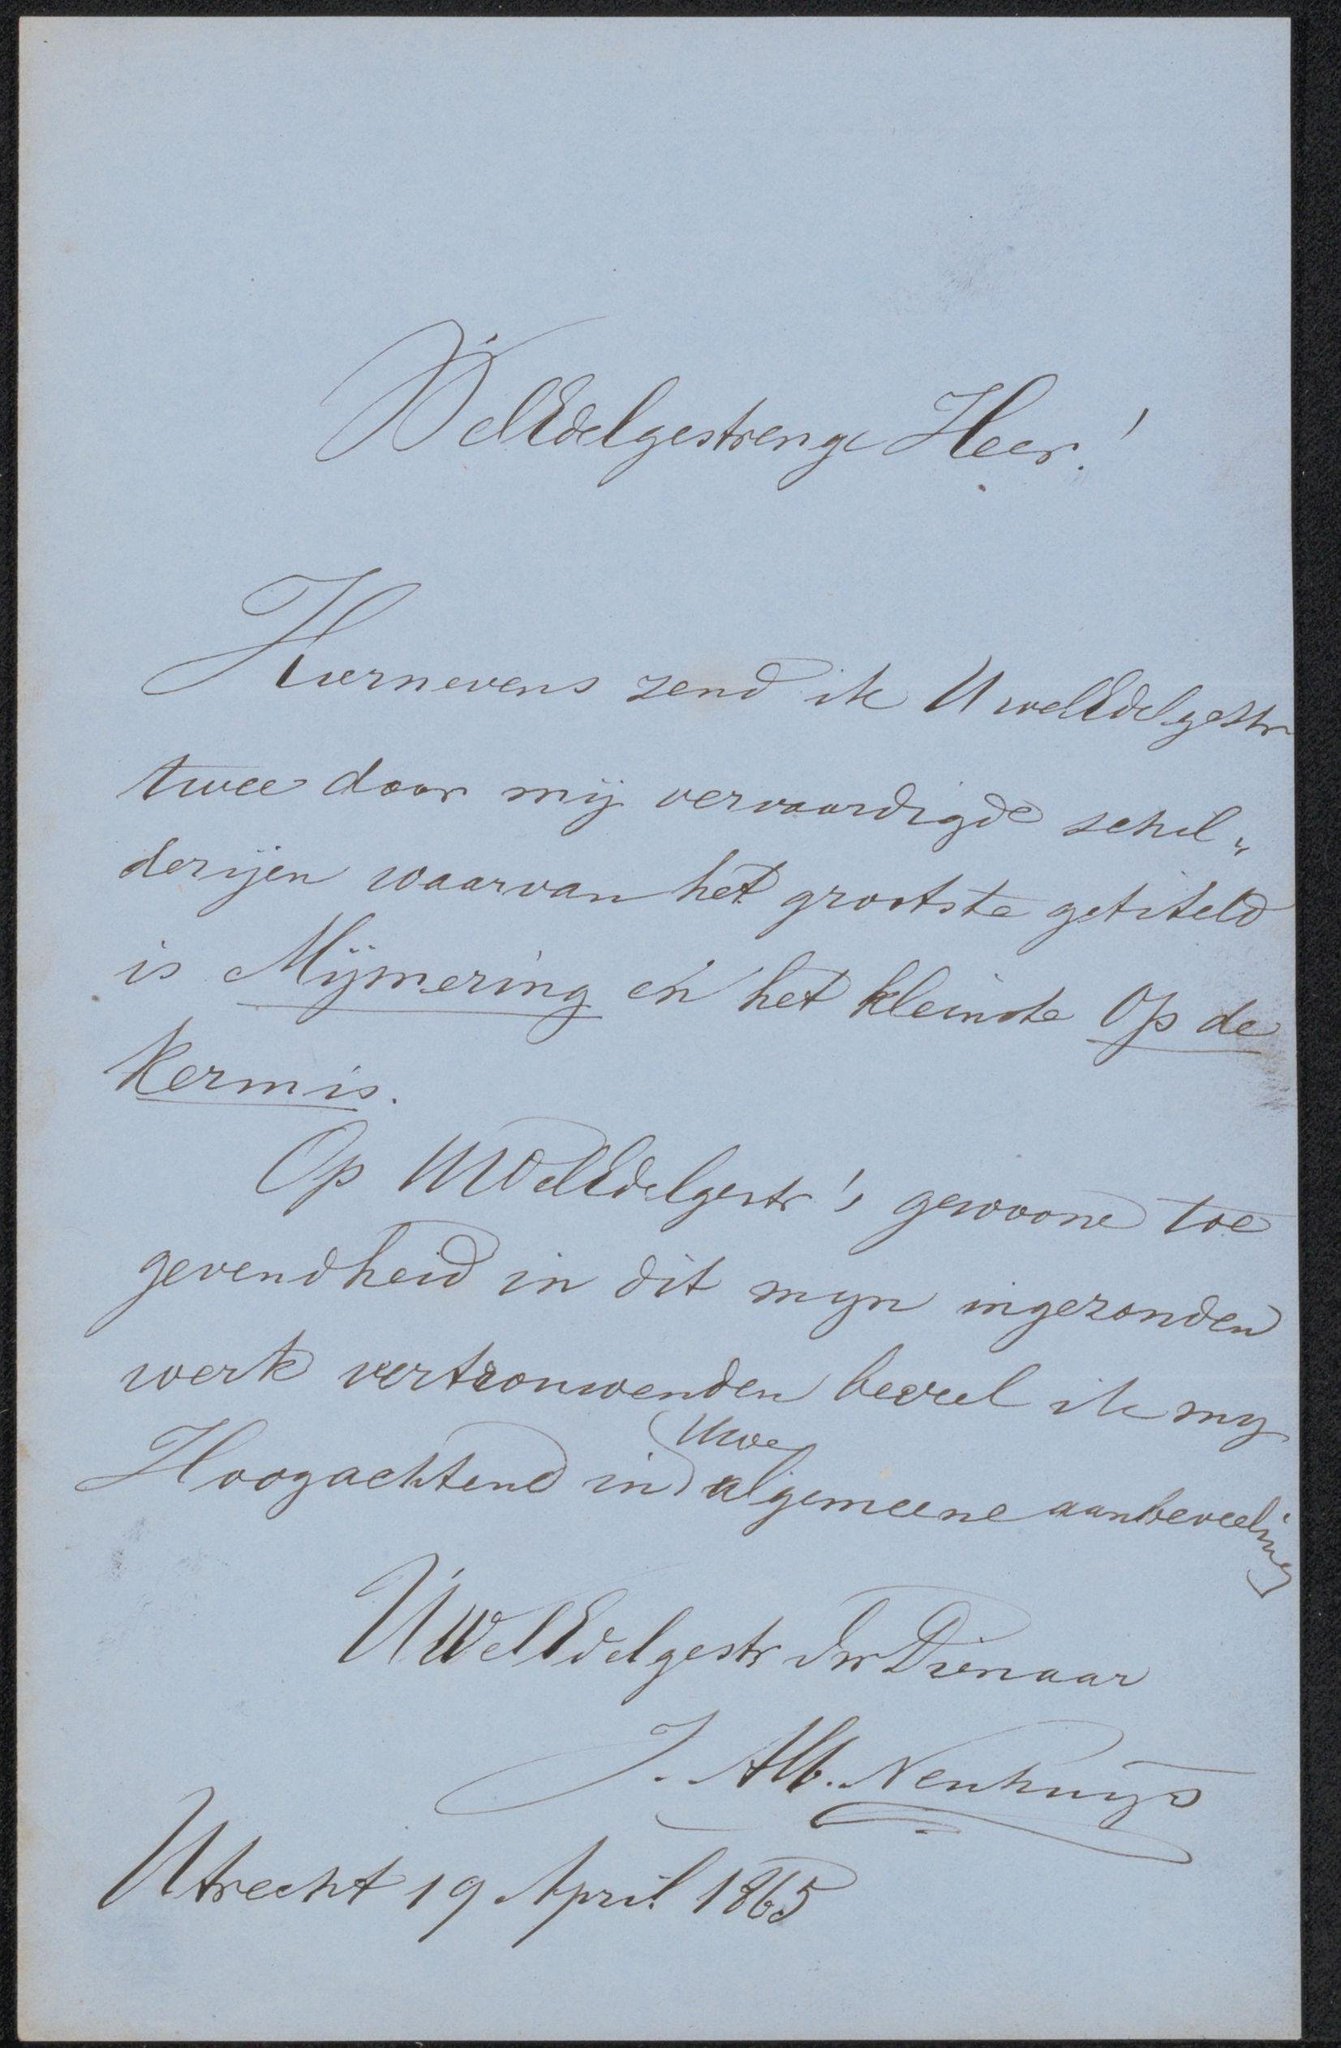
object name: letter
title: Brief aan anoniem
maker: albert neuhuys (1844-1914)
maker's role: draughtsman, painter, print maker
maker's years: 1844-1914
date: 1865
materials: ink, paper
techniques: pen, writing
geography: utrecht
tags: painting (including book-illumination, miniature-painting), money